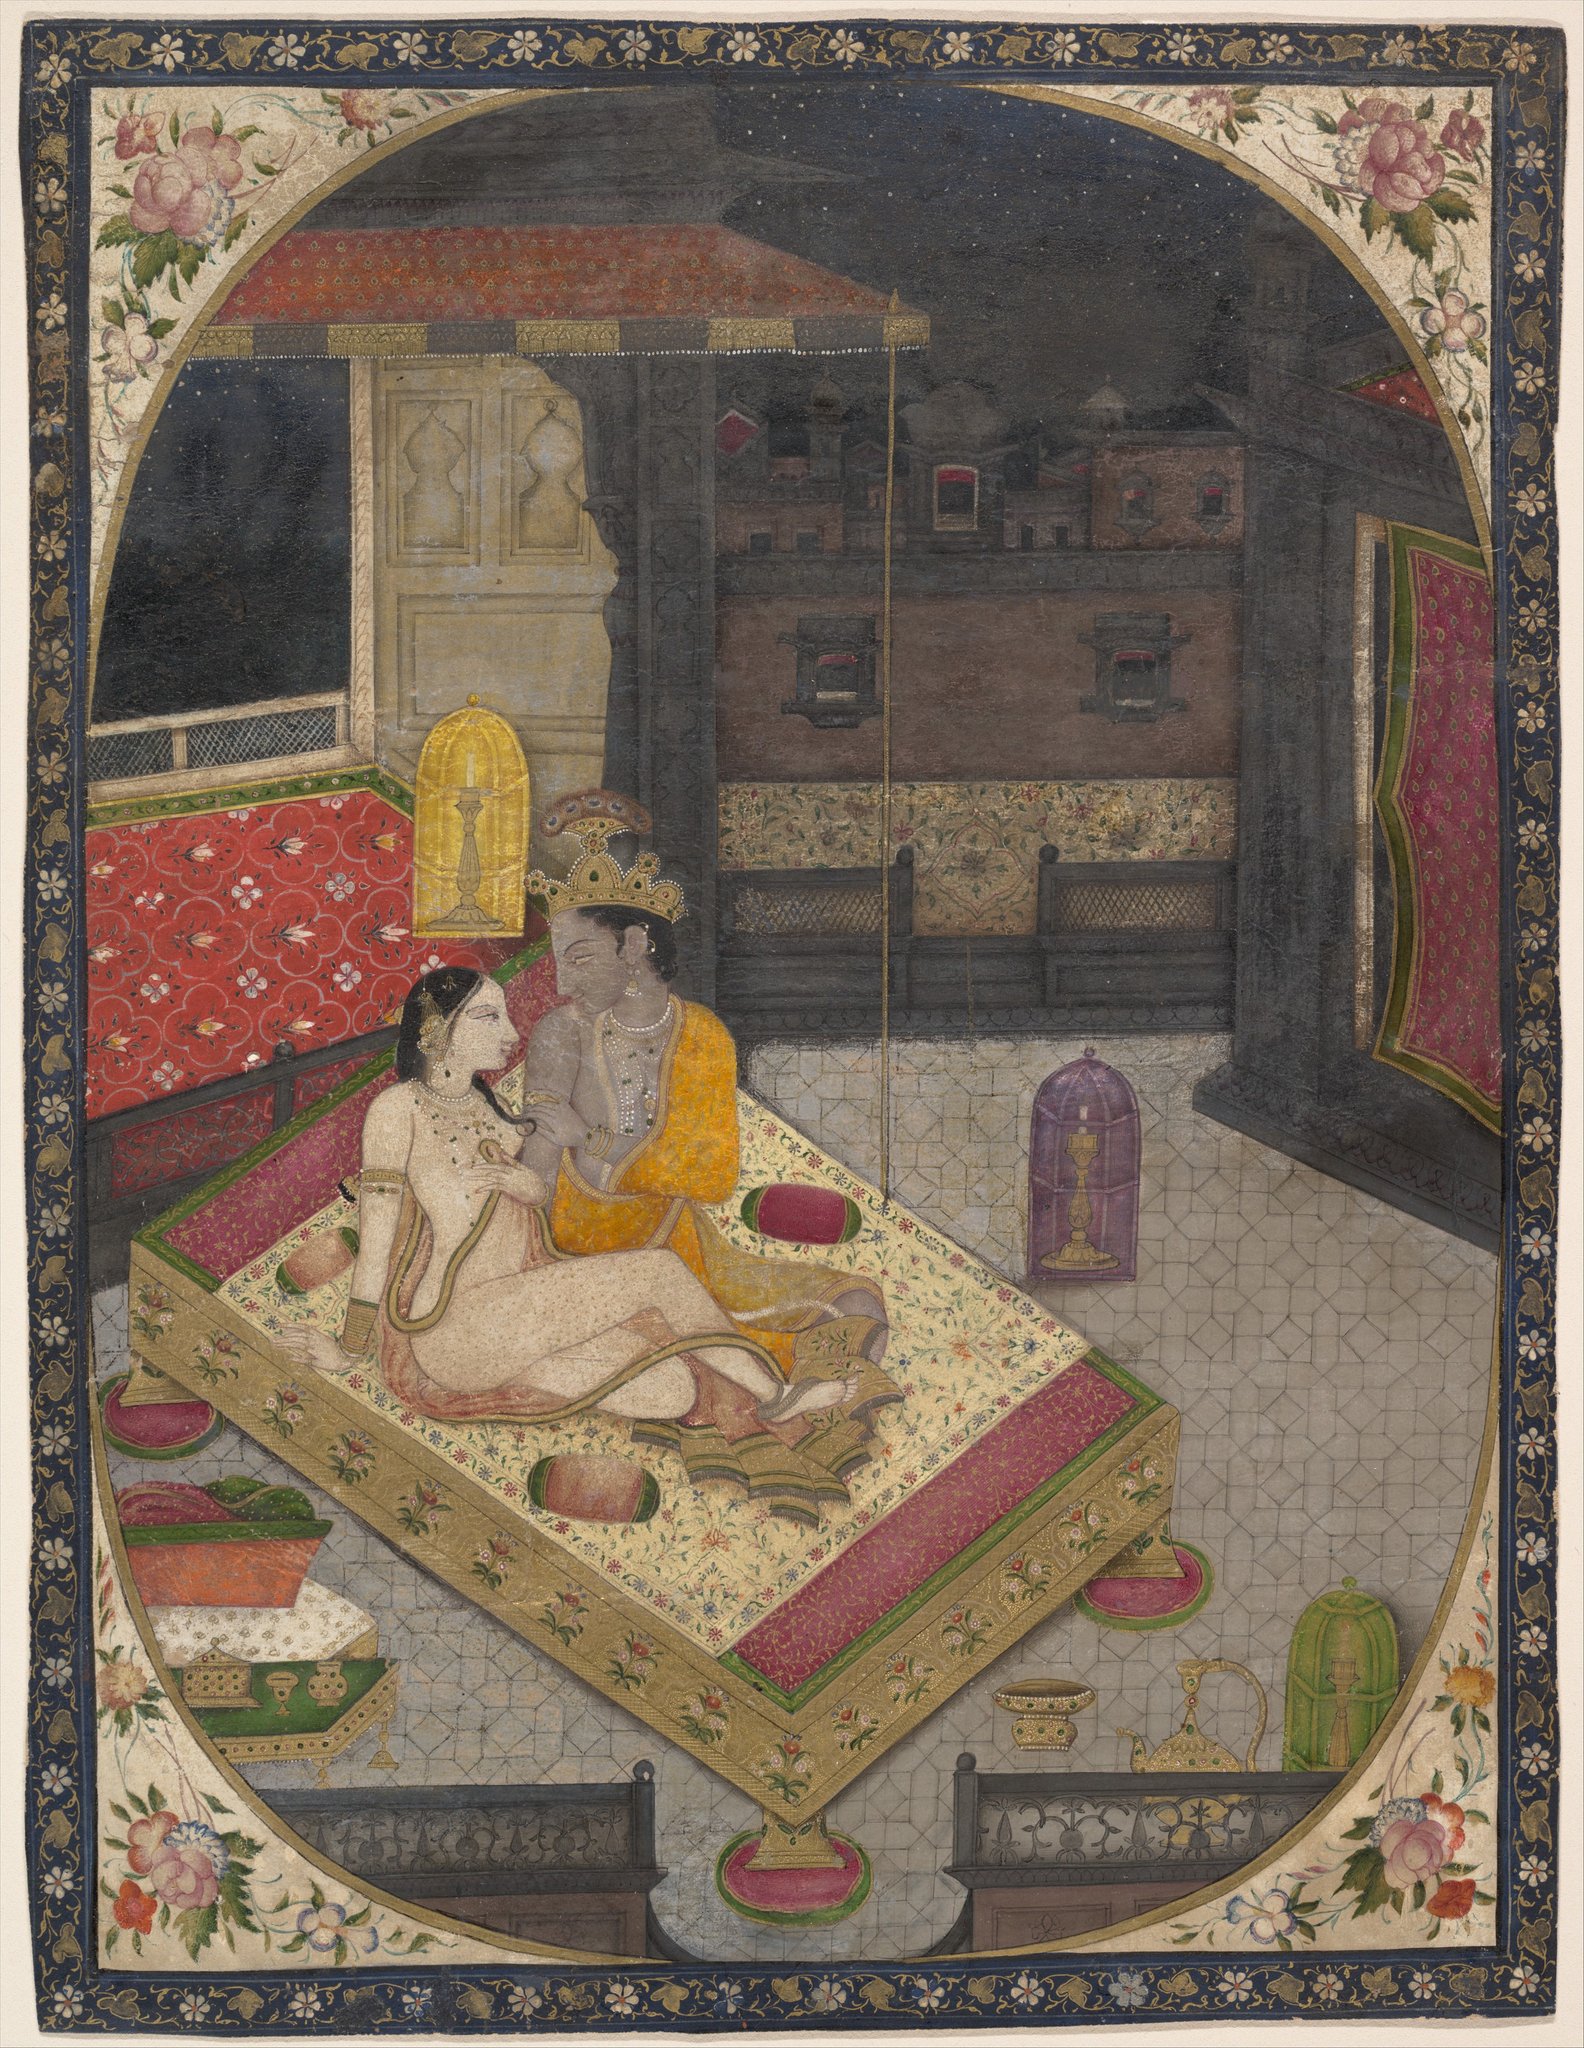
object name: painting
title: Radha and Krishna on a Bed at Night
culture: indian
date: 1830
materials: ink, paper, watercolor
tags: interiors,men,women,krishna,radha,beds